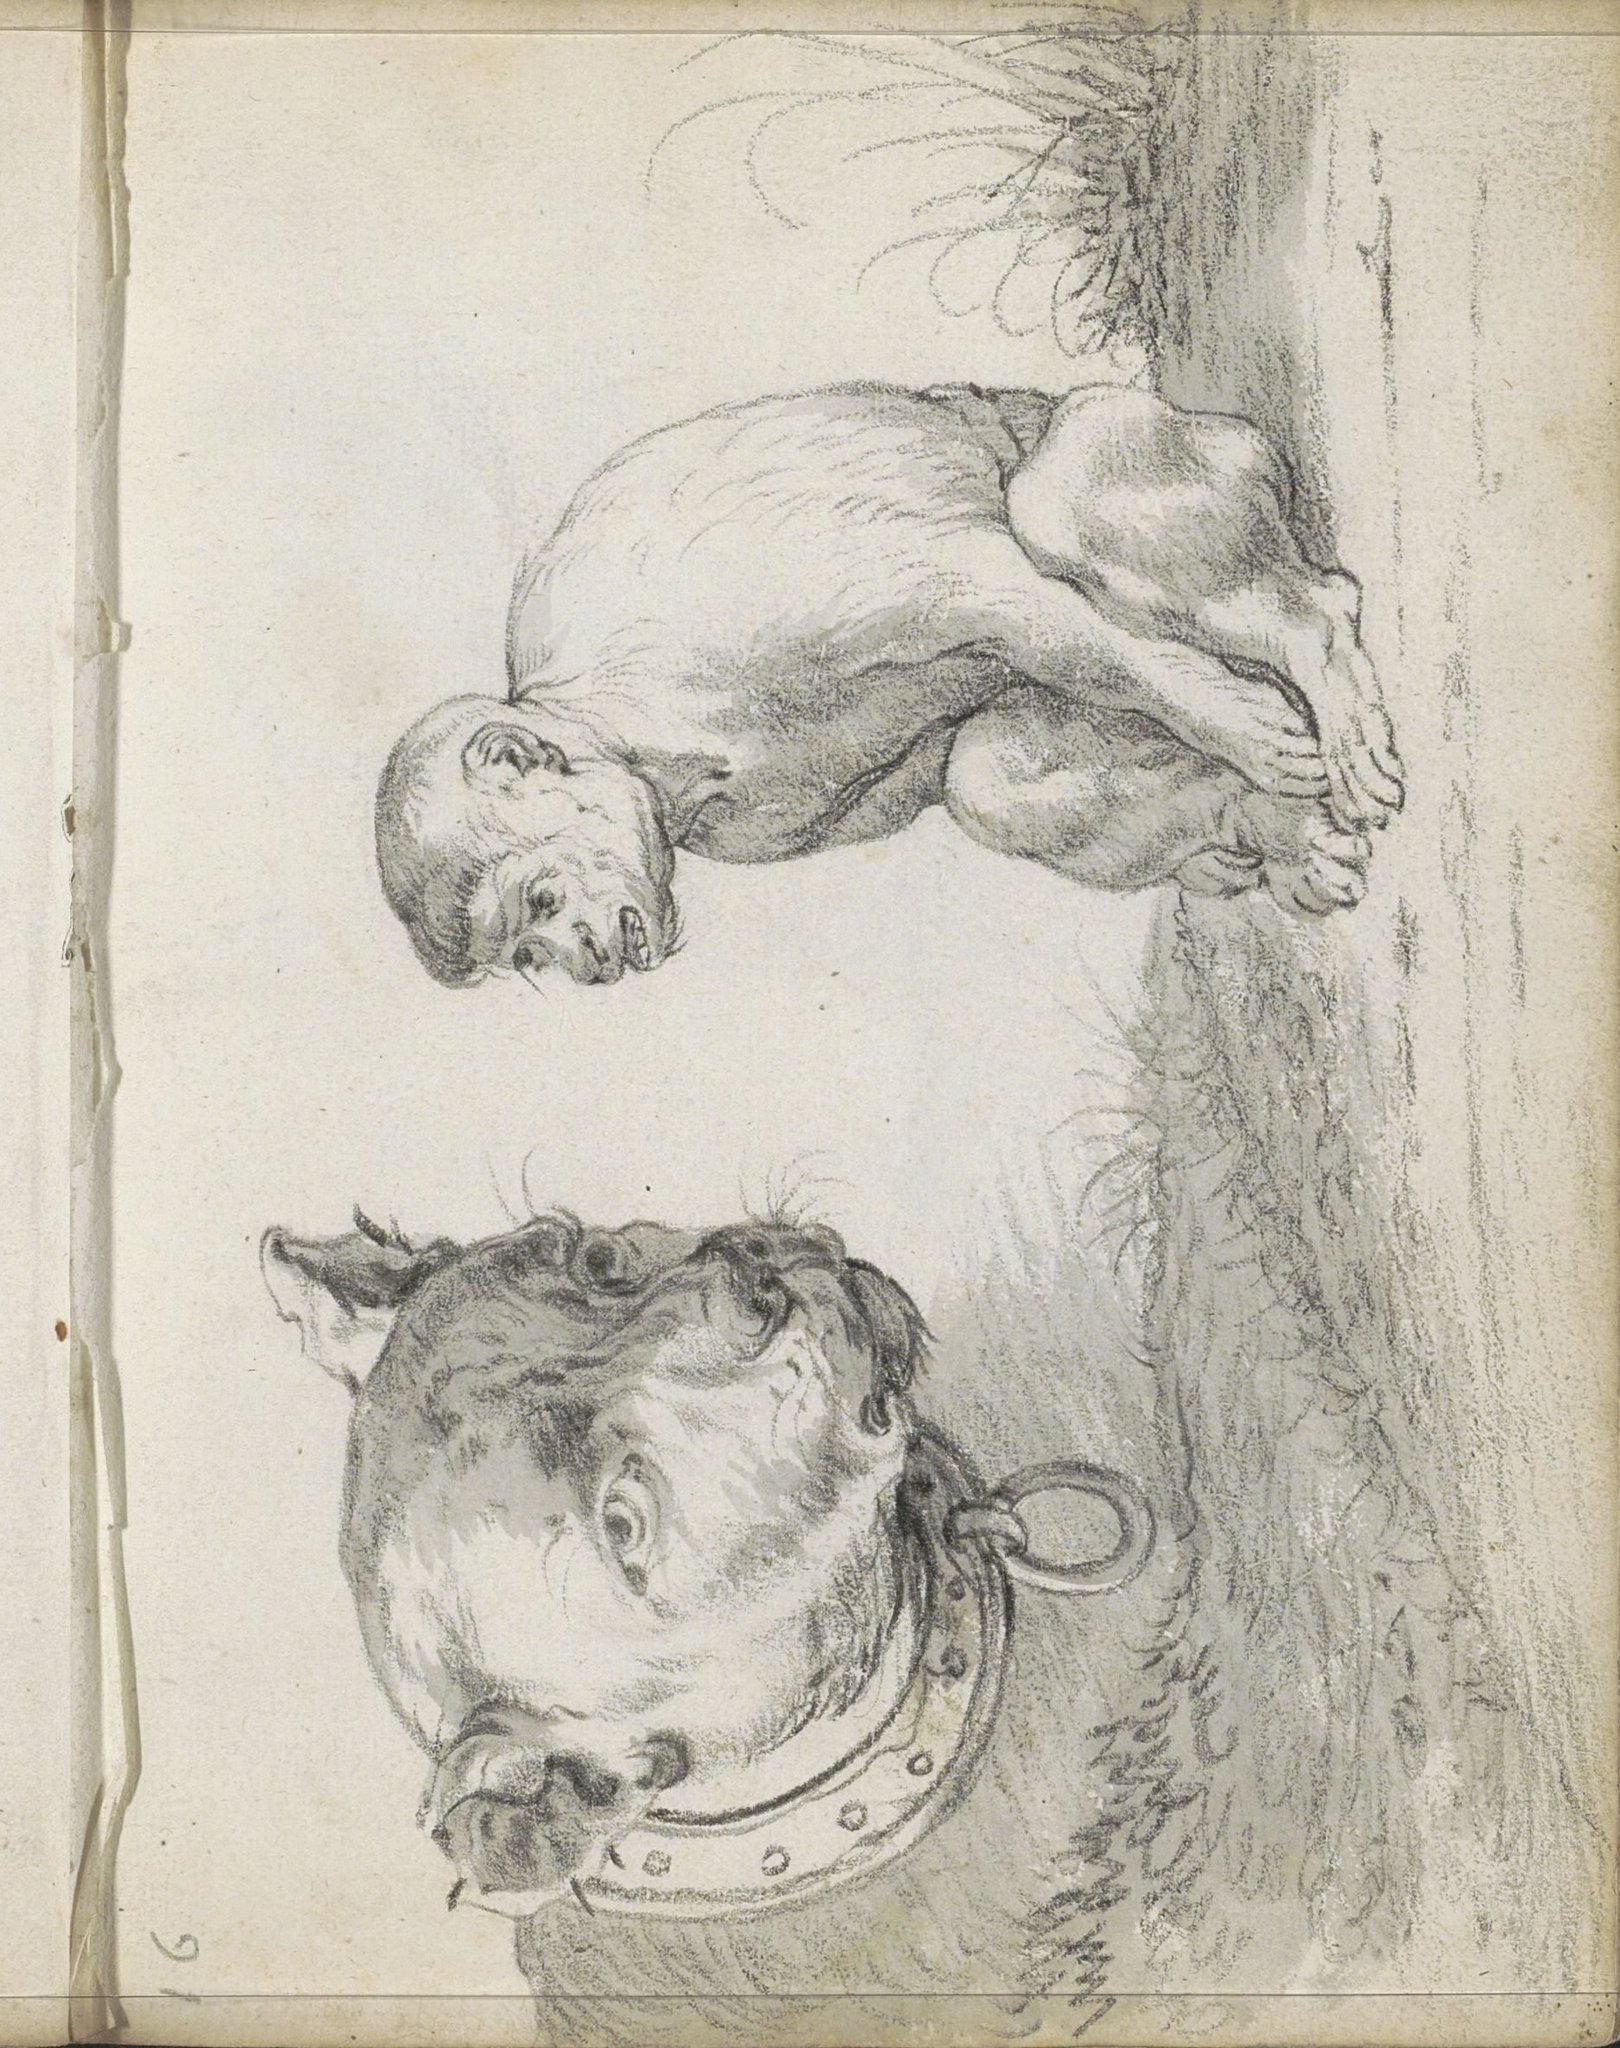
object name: sketchbook leaf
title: Kop van een hond en een aap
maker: cornelis saftleven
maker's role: draughtsman, painter, print maker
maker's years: 1607-1681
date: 1666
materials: chalk, ink, paper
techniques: brush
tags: monkeys, apes, dog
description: Blad 16 recto uit een schetsboek met 49 bladen.